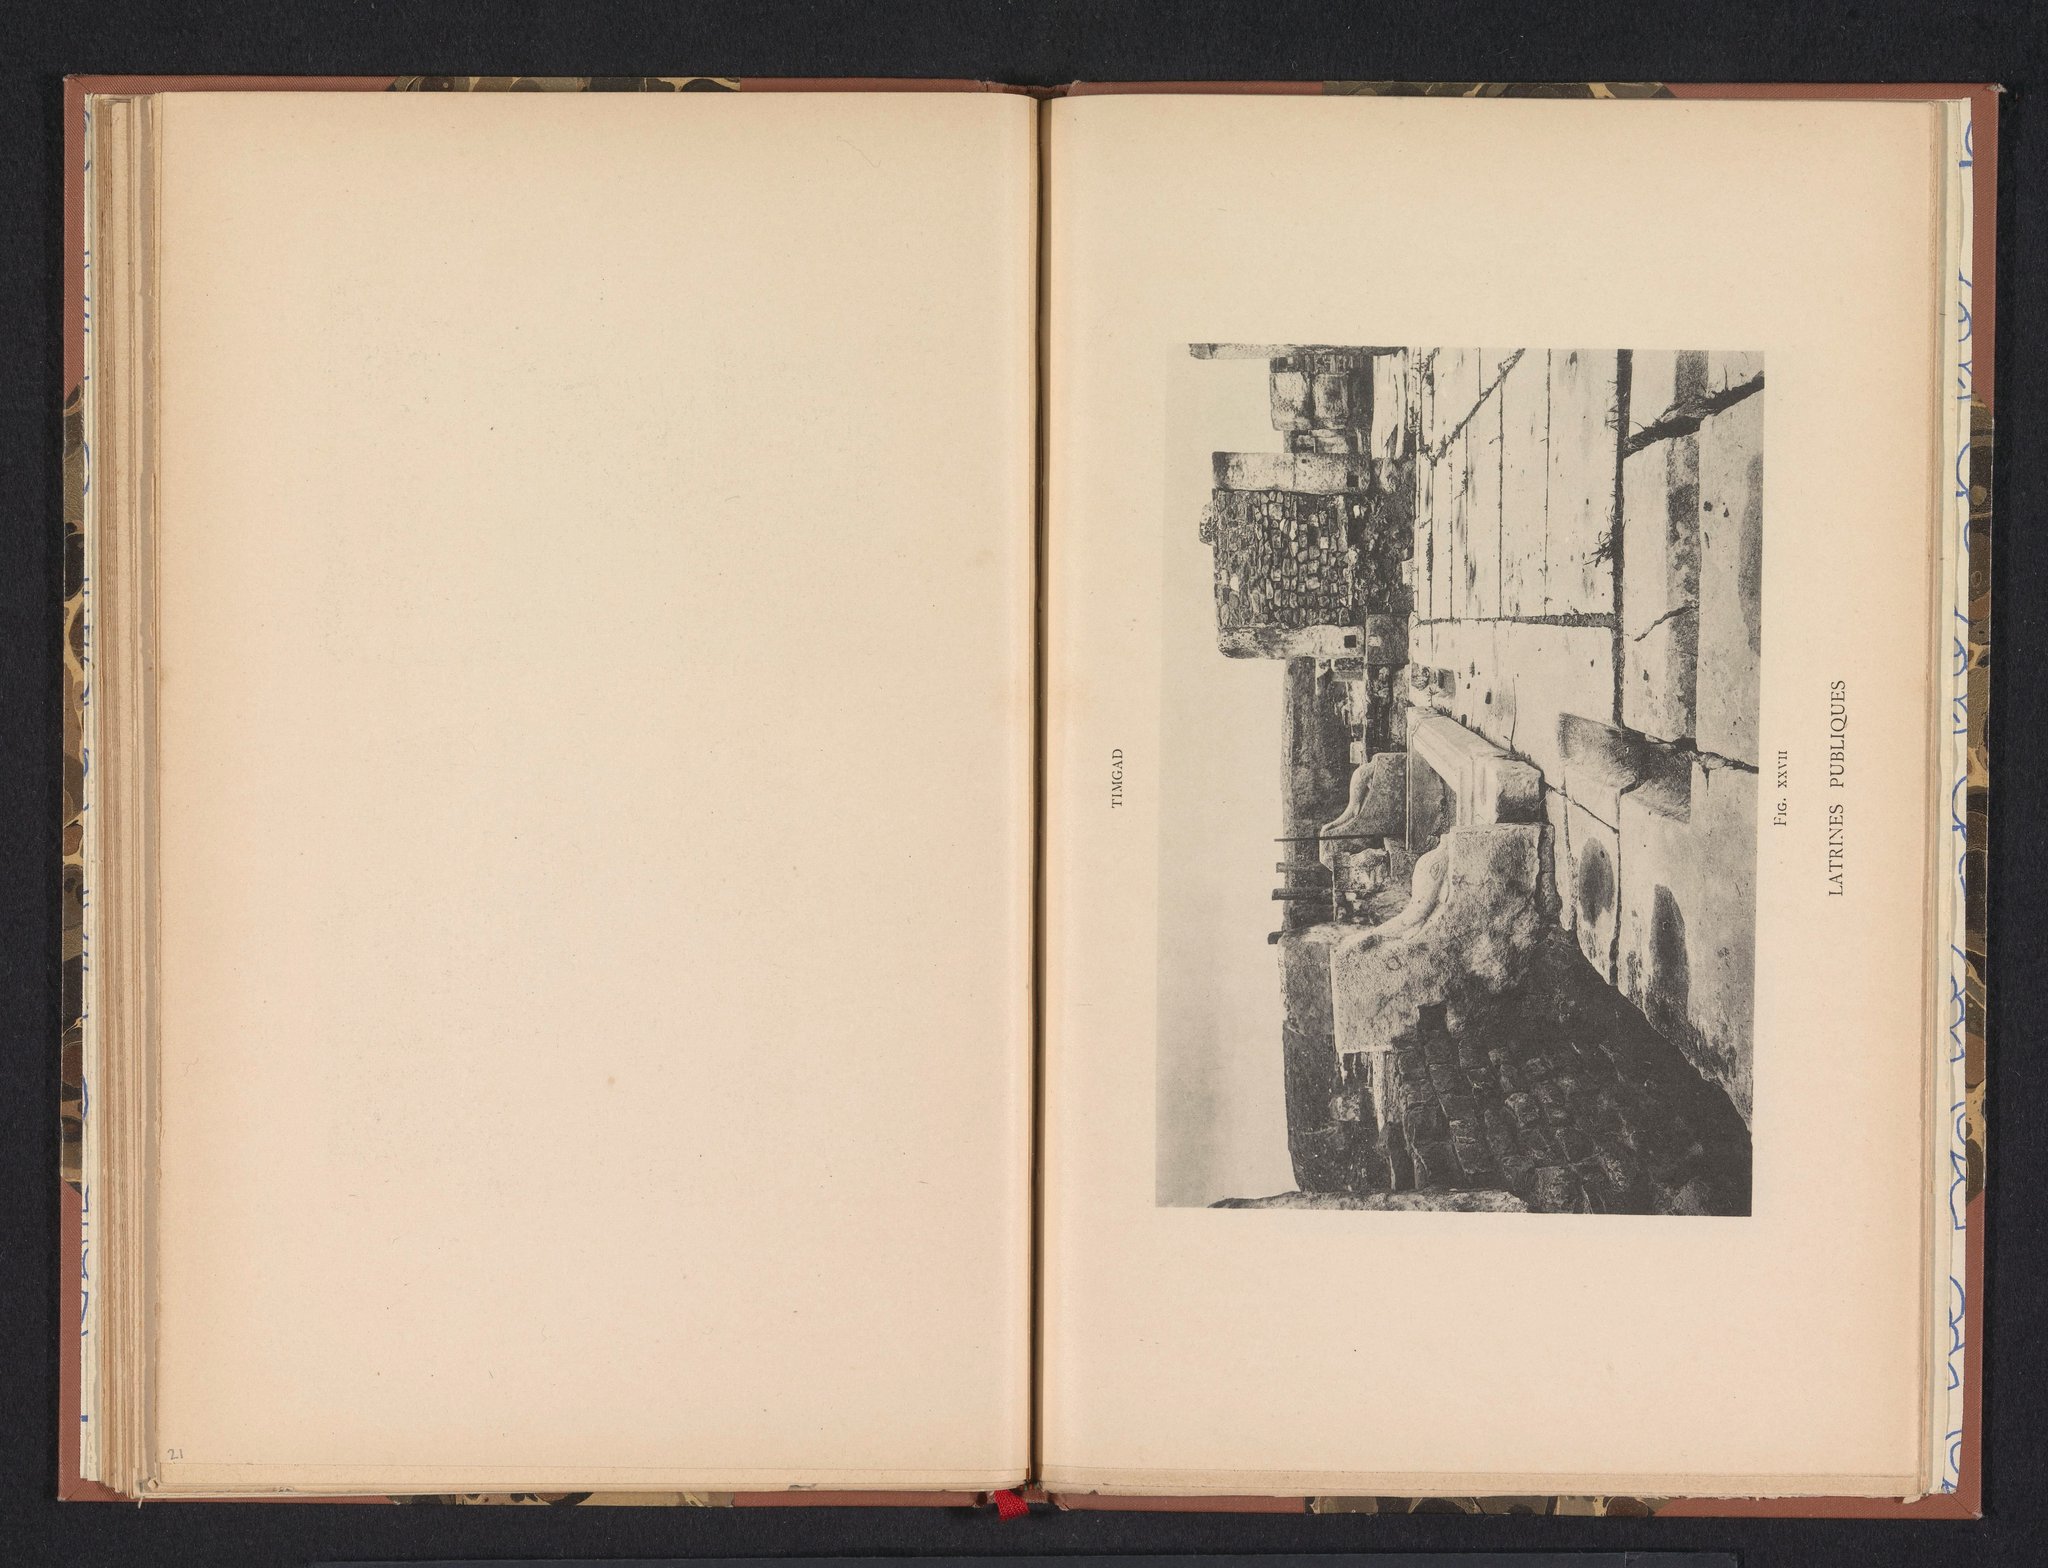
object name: photomechanical print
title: Gezicht op de Romeinse ruïne van een openbare latrine in Timgad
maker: Anonymous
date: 1884-1894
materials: paper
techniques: photograph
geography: timgad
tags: landscape with ruins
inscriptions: number: ‘Fig. XXVII’